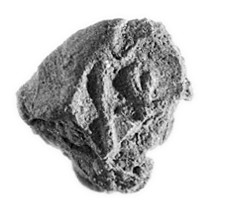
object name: sealing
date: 2030-1640 BCE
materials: clay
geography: egypt